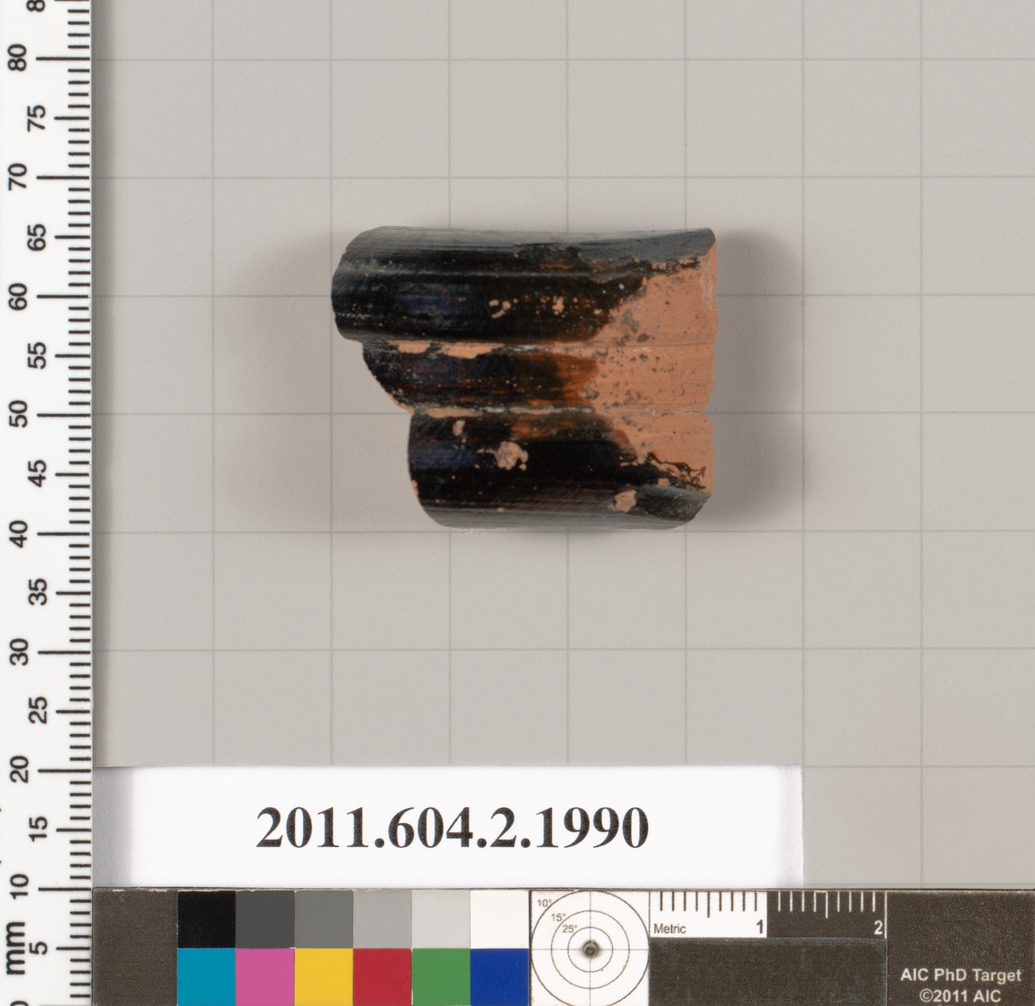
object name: neck amphora fragment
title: Terracotta fragment of a Neck-amphora (jar)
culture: greek, attic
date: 475-451 BCE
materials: terracotta